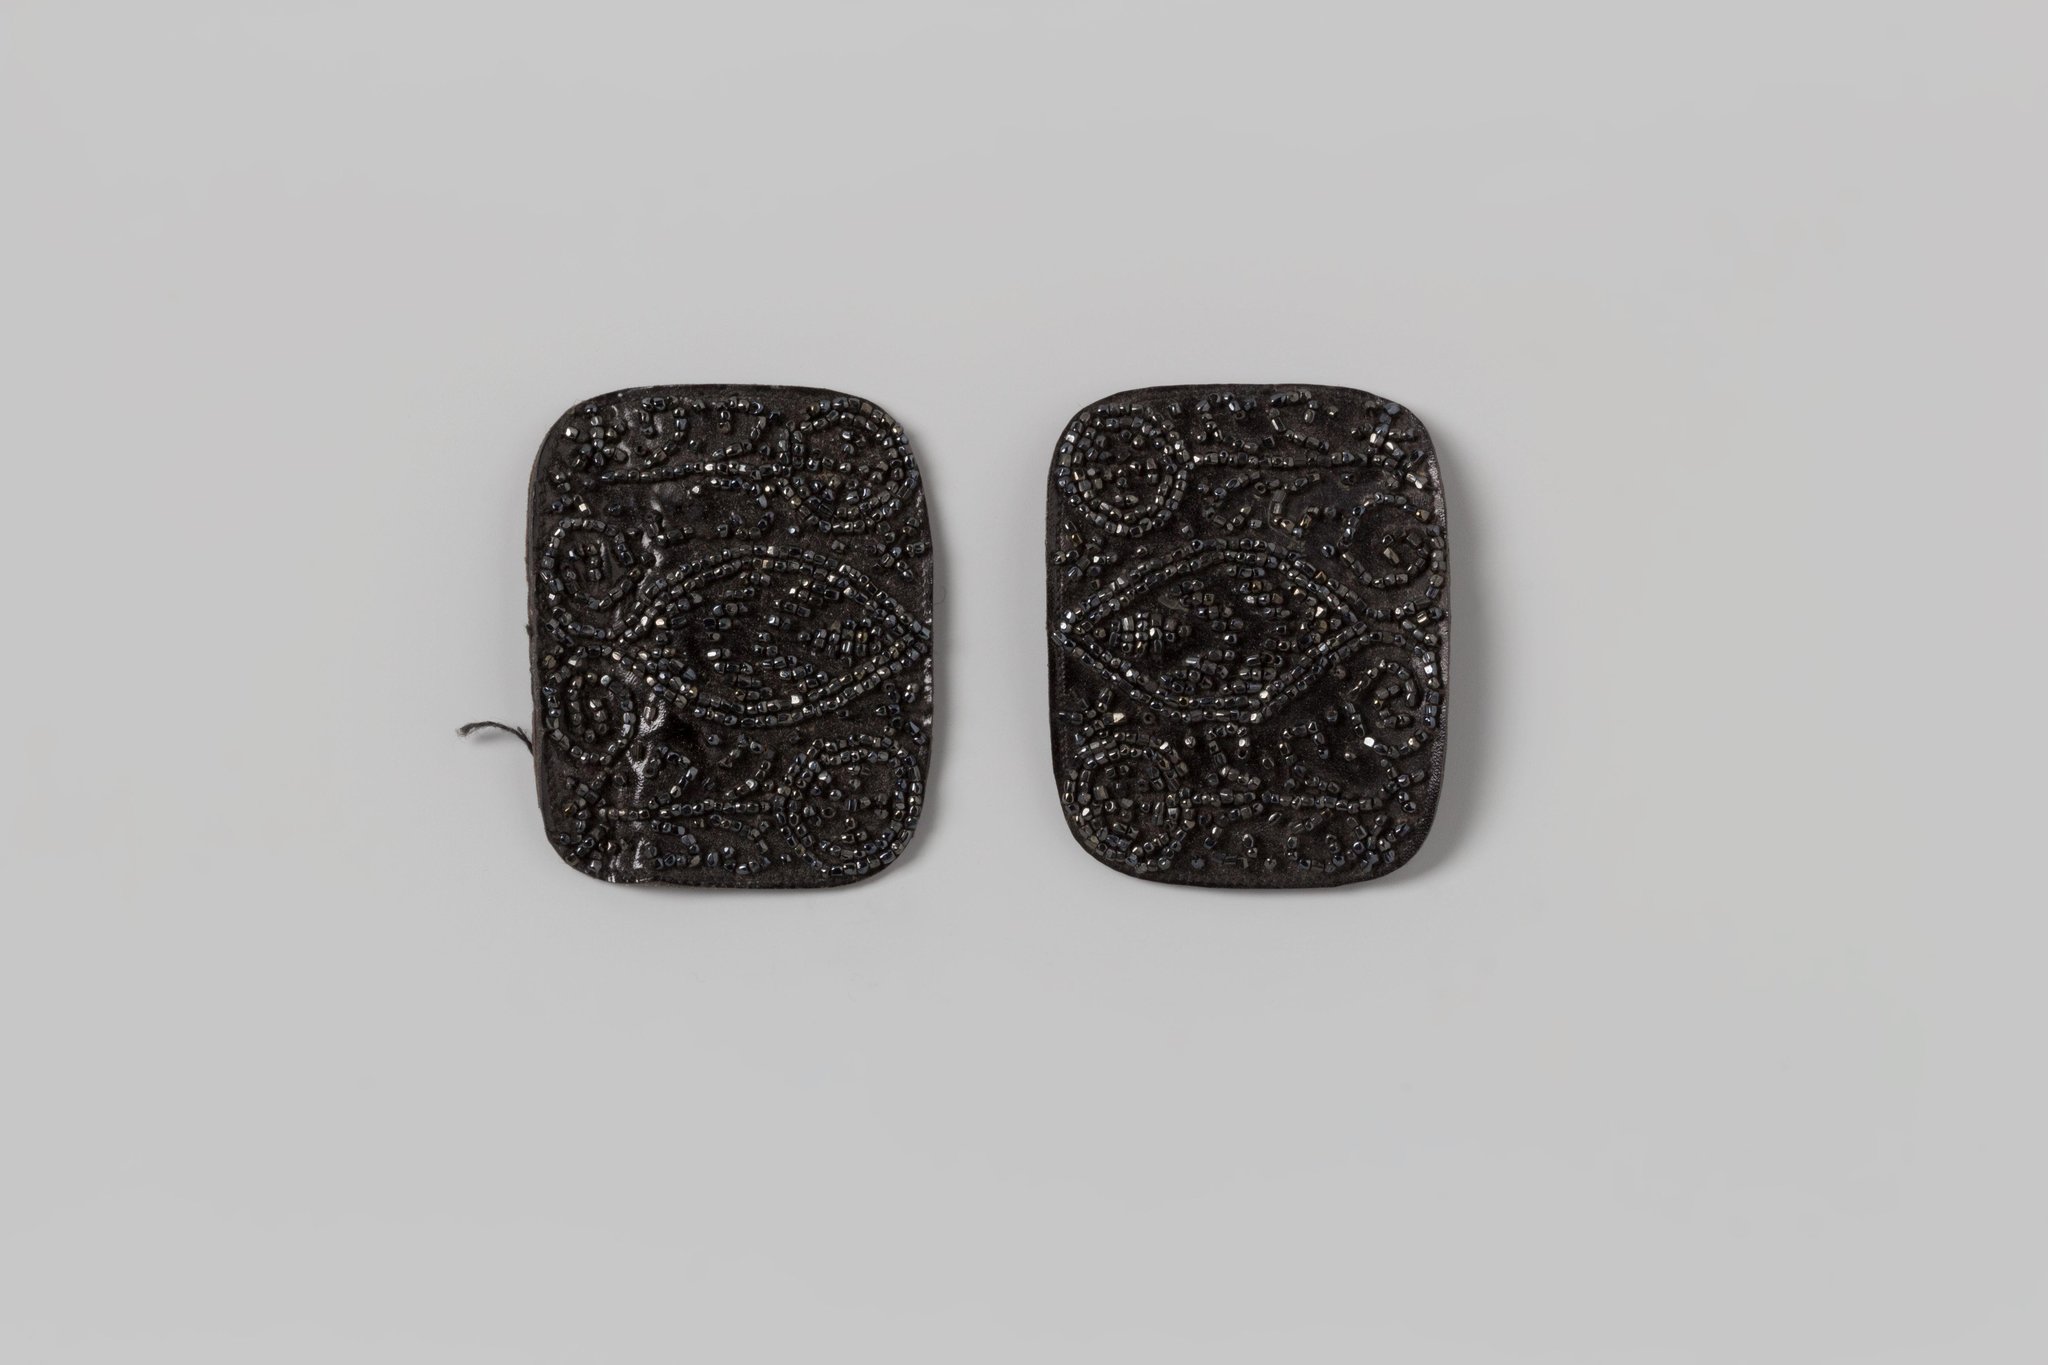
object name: shoe buckle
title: Schoengesp van zwart leer geborduurd met gitten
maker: Anonymous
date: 1915-1920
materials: jet, leather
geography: france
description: Schoengesp van zwart leer geborduurd met gitten. Rechthoekig gesloten model van zwart leer op een verstevigde ondergrond. Het borduursel bestaat uit een ovaal blad, geflankeerd door twee ronde bloemen op een stengel.